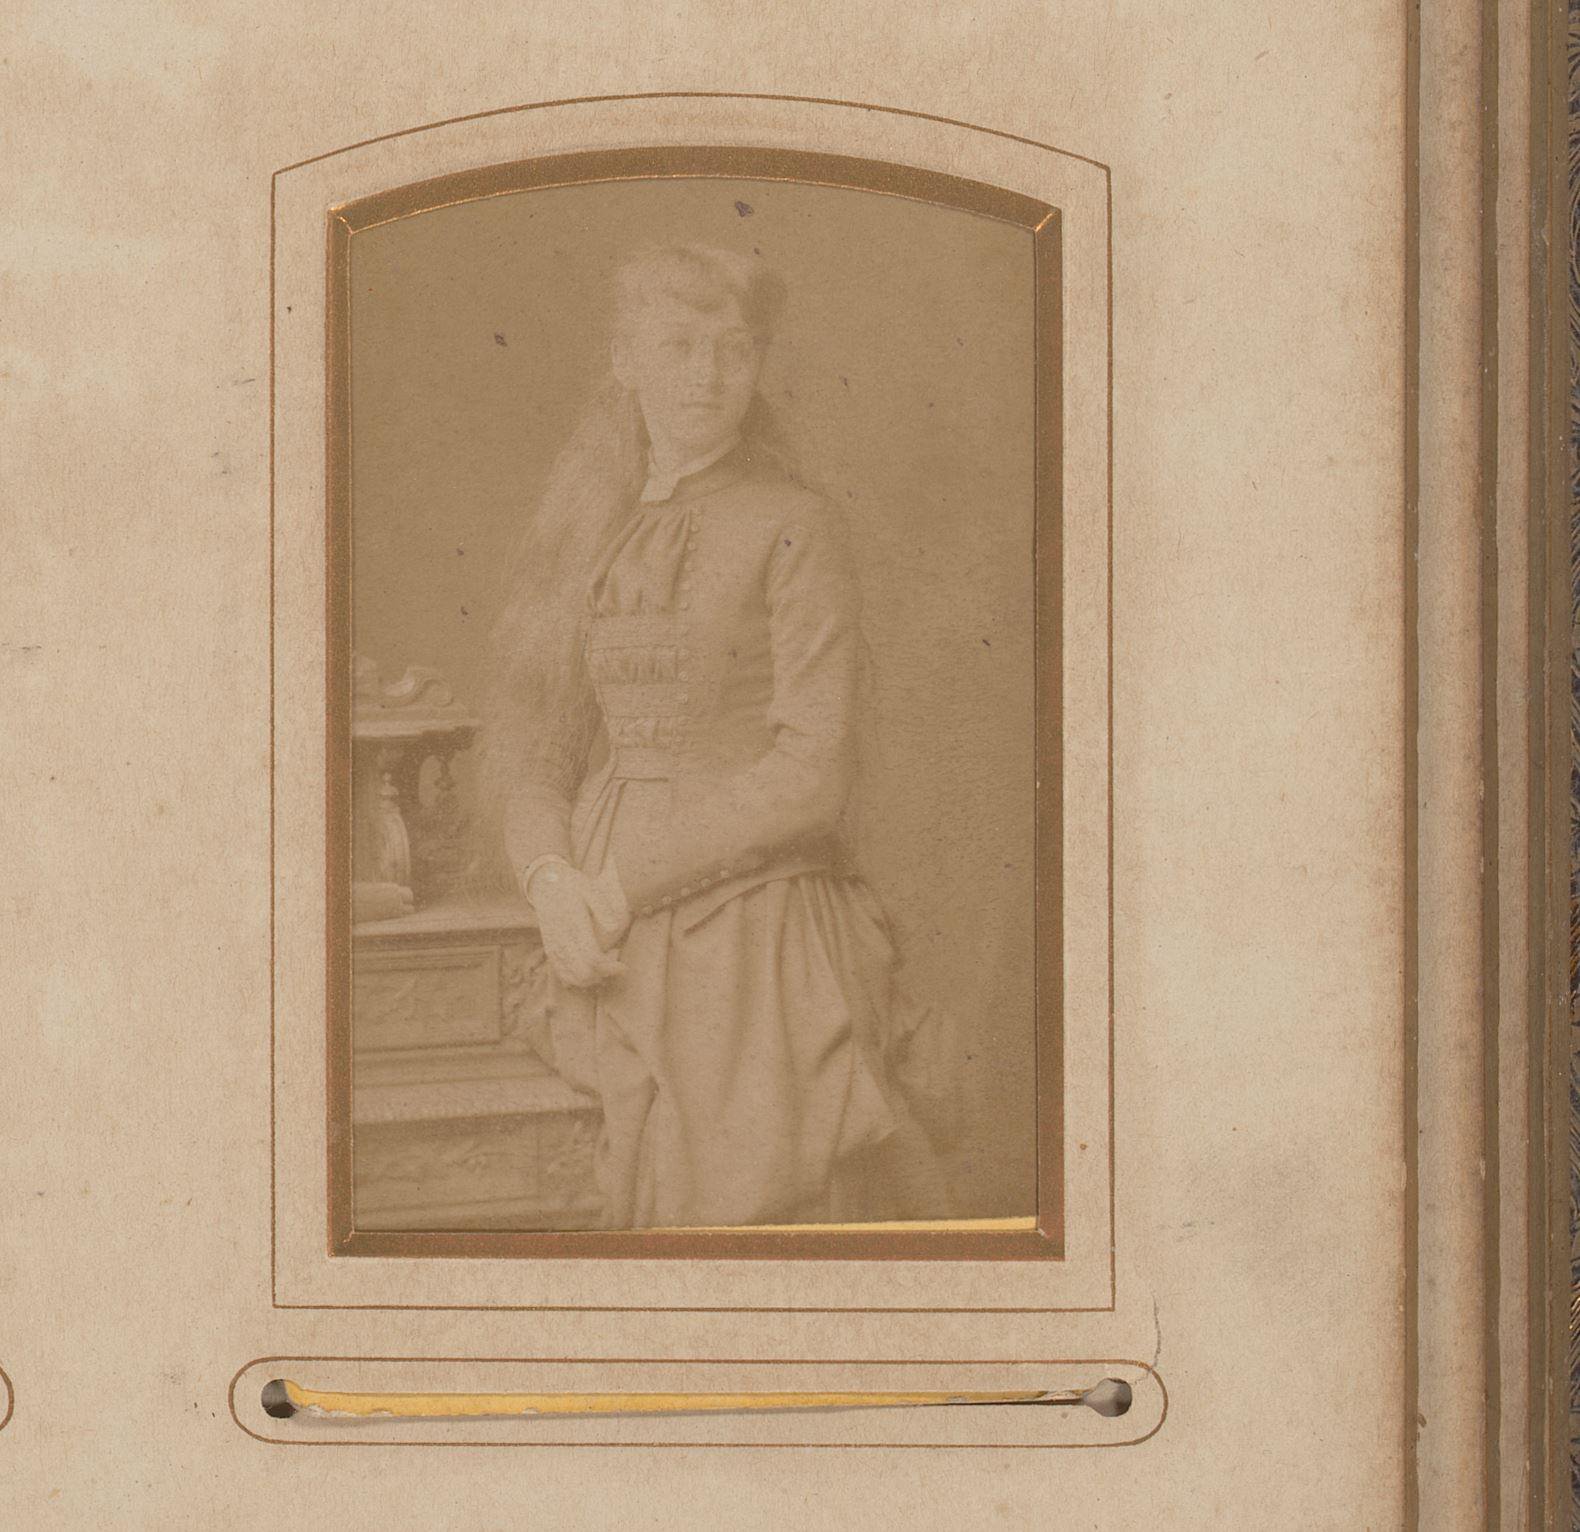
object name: carte de visite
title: Portret van een meisje, staand bij een schrijftafel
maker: ferdinand fussen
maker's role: fotograaf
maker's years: 1844-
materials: cardboard, photographic support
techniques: albumen print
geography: brussels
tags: writing-table, writing-desk, historical persons - bb - woman, girl (child between toddler and youth), standing figure - aa - female human figure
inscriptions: inscription: ‘SCIENCE ET ART/ F. Fussen & Cie./ 108, BOULEVARD DU NORD, 108/ BRUXELLES’